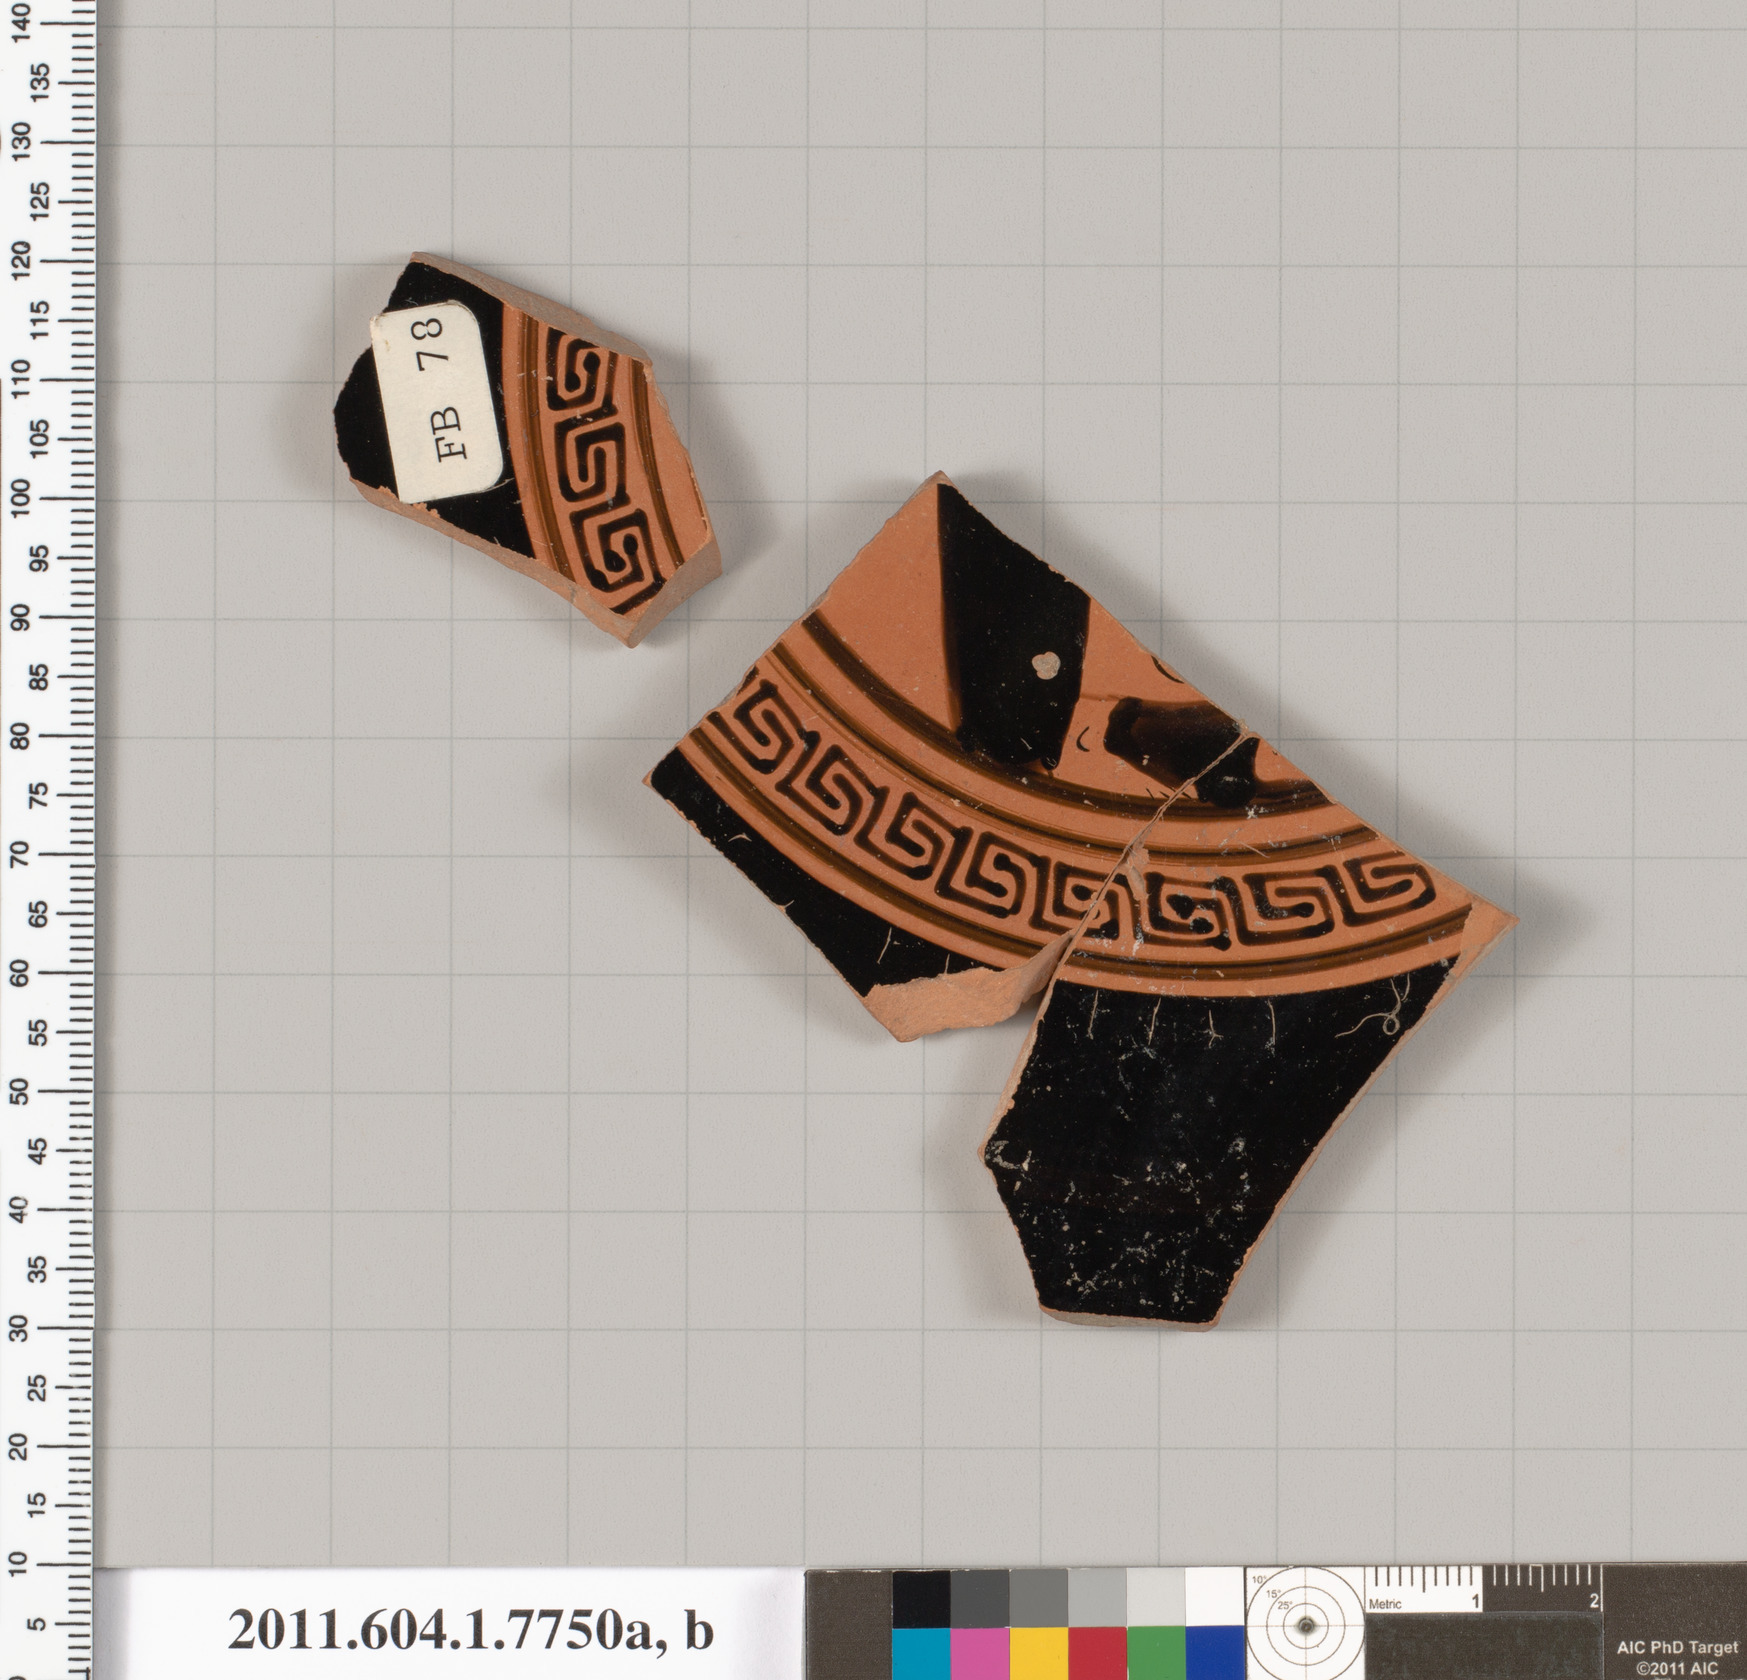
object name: kylix fragment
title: Terracotta fragments of a kylix (drinking cup)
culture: greek, attic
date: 460-450 BCE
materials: terracotta